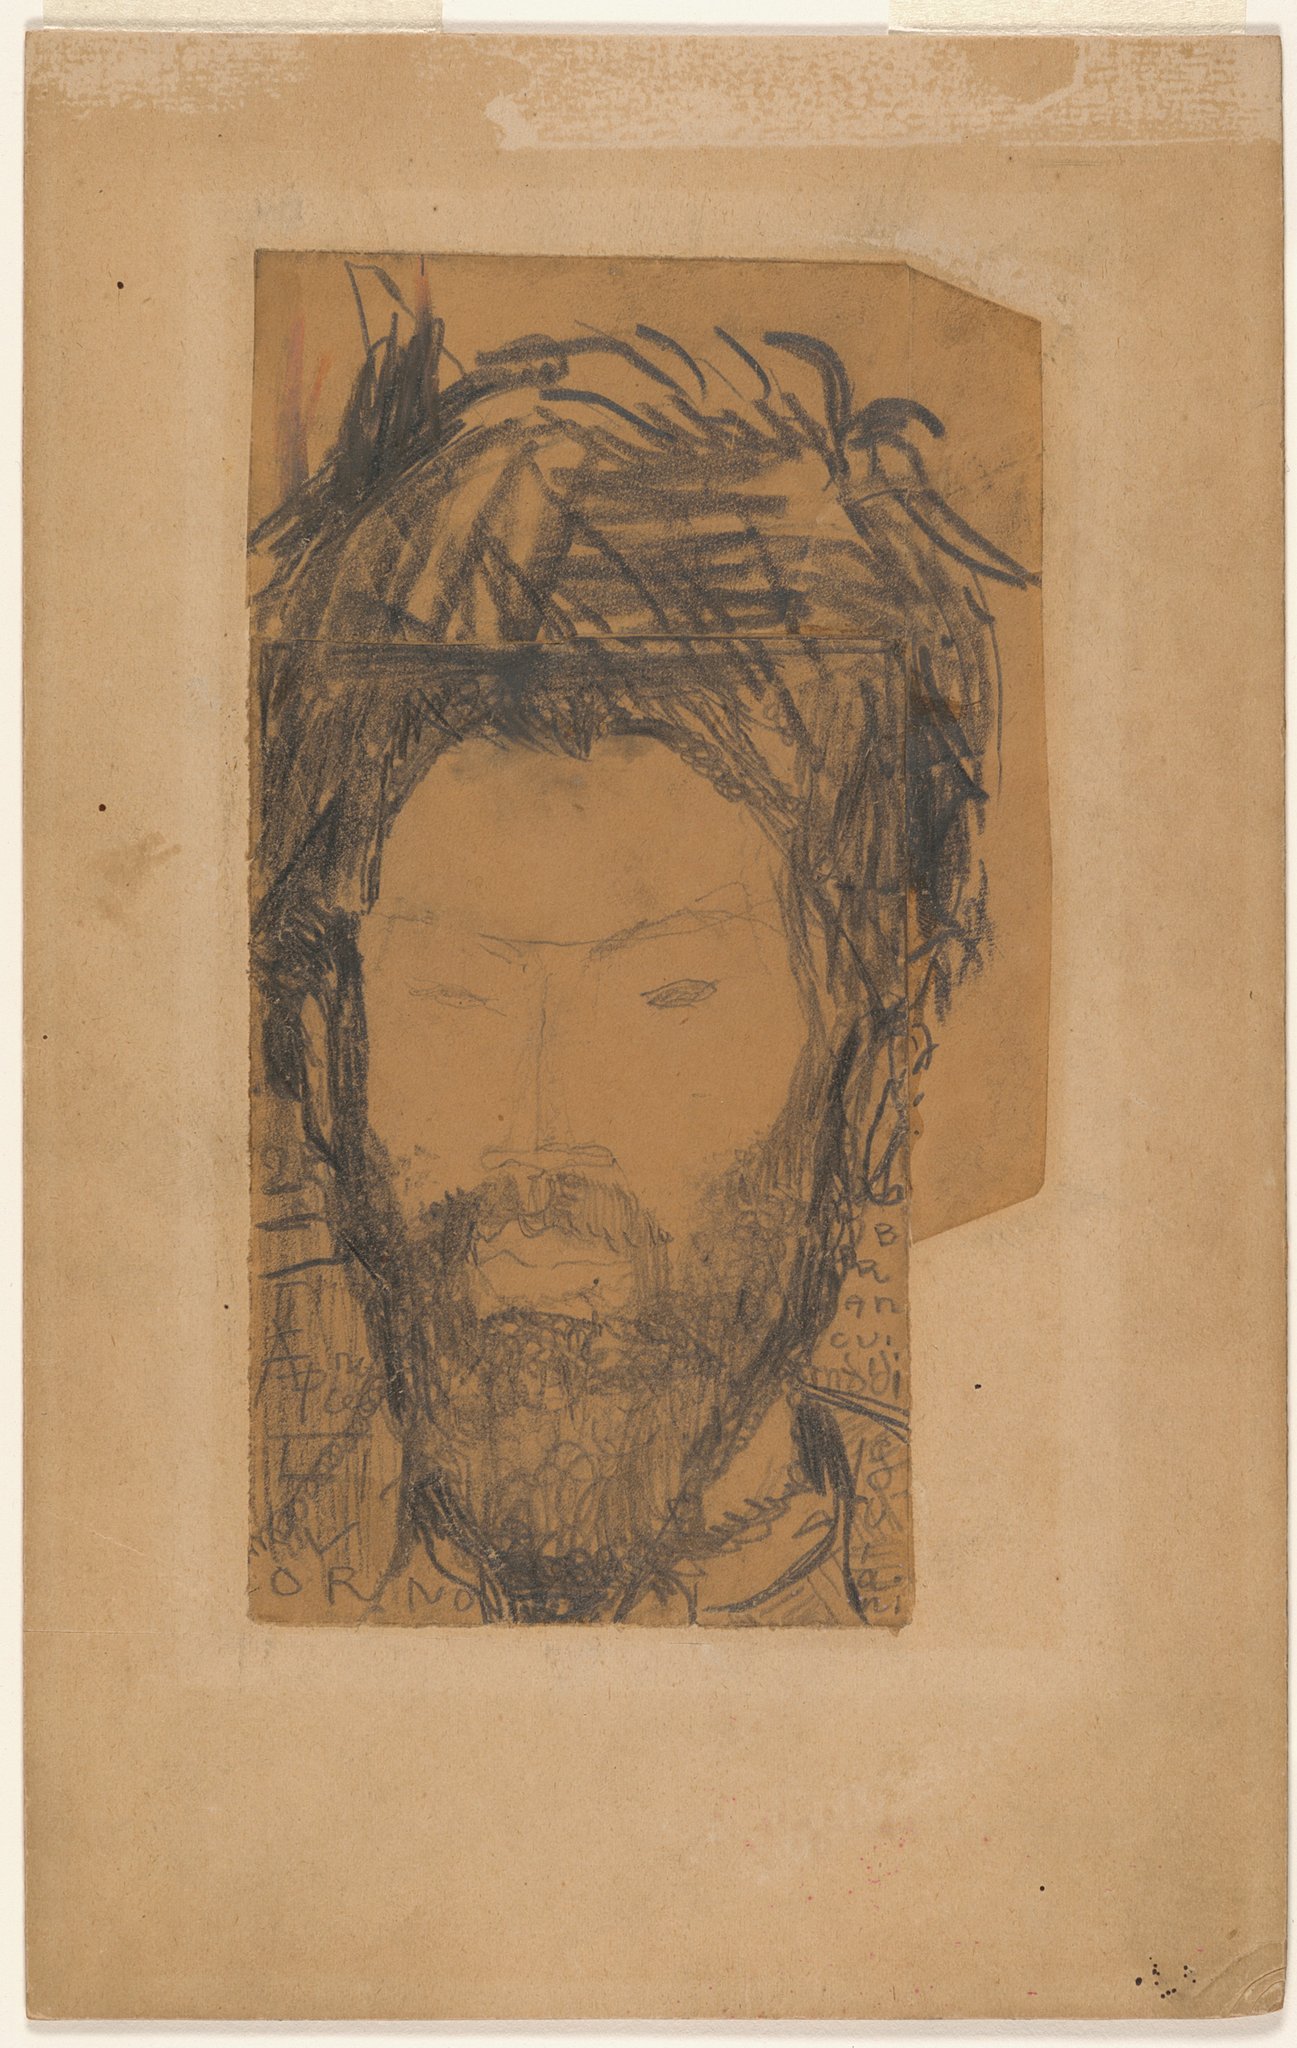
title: Constantin Brancusi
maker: amedeo modigliani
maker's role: artist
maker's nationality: italian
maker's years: 1884-1920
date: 1909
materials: board, crayon, graphite, paper